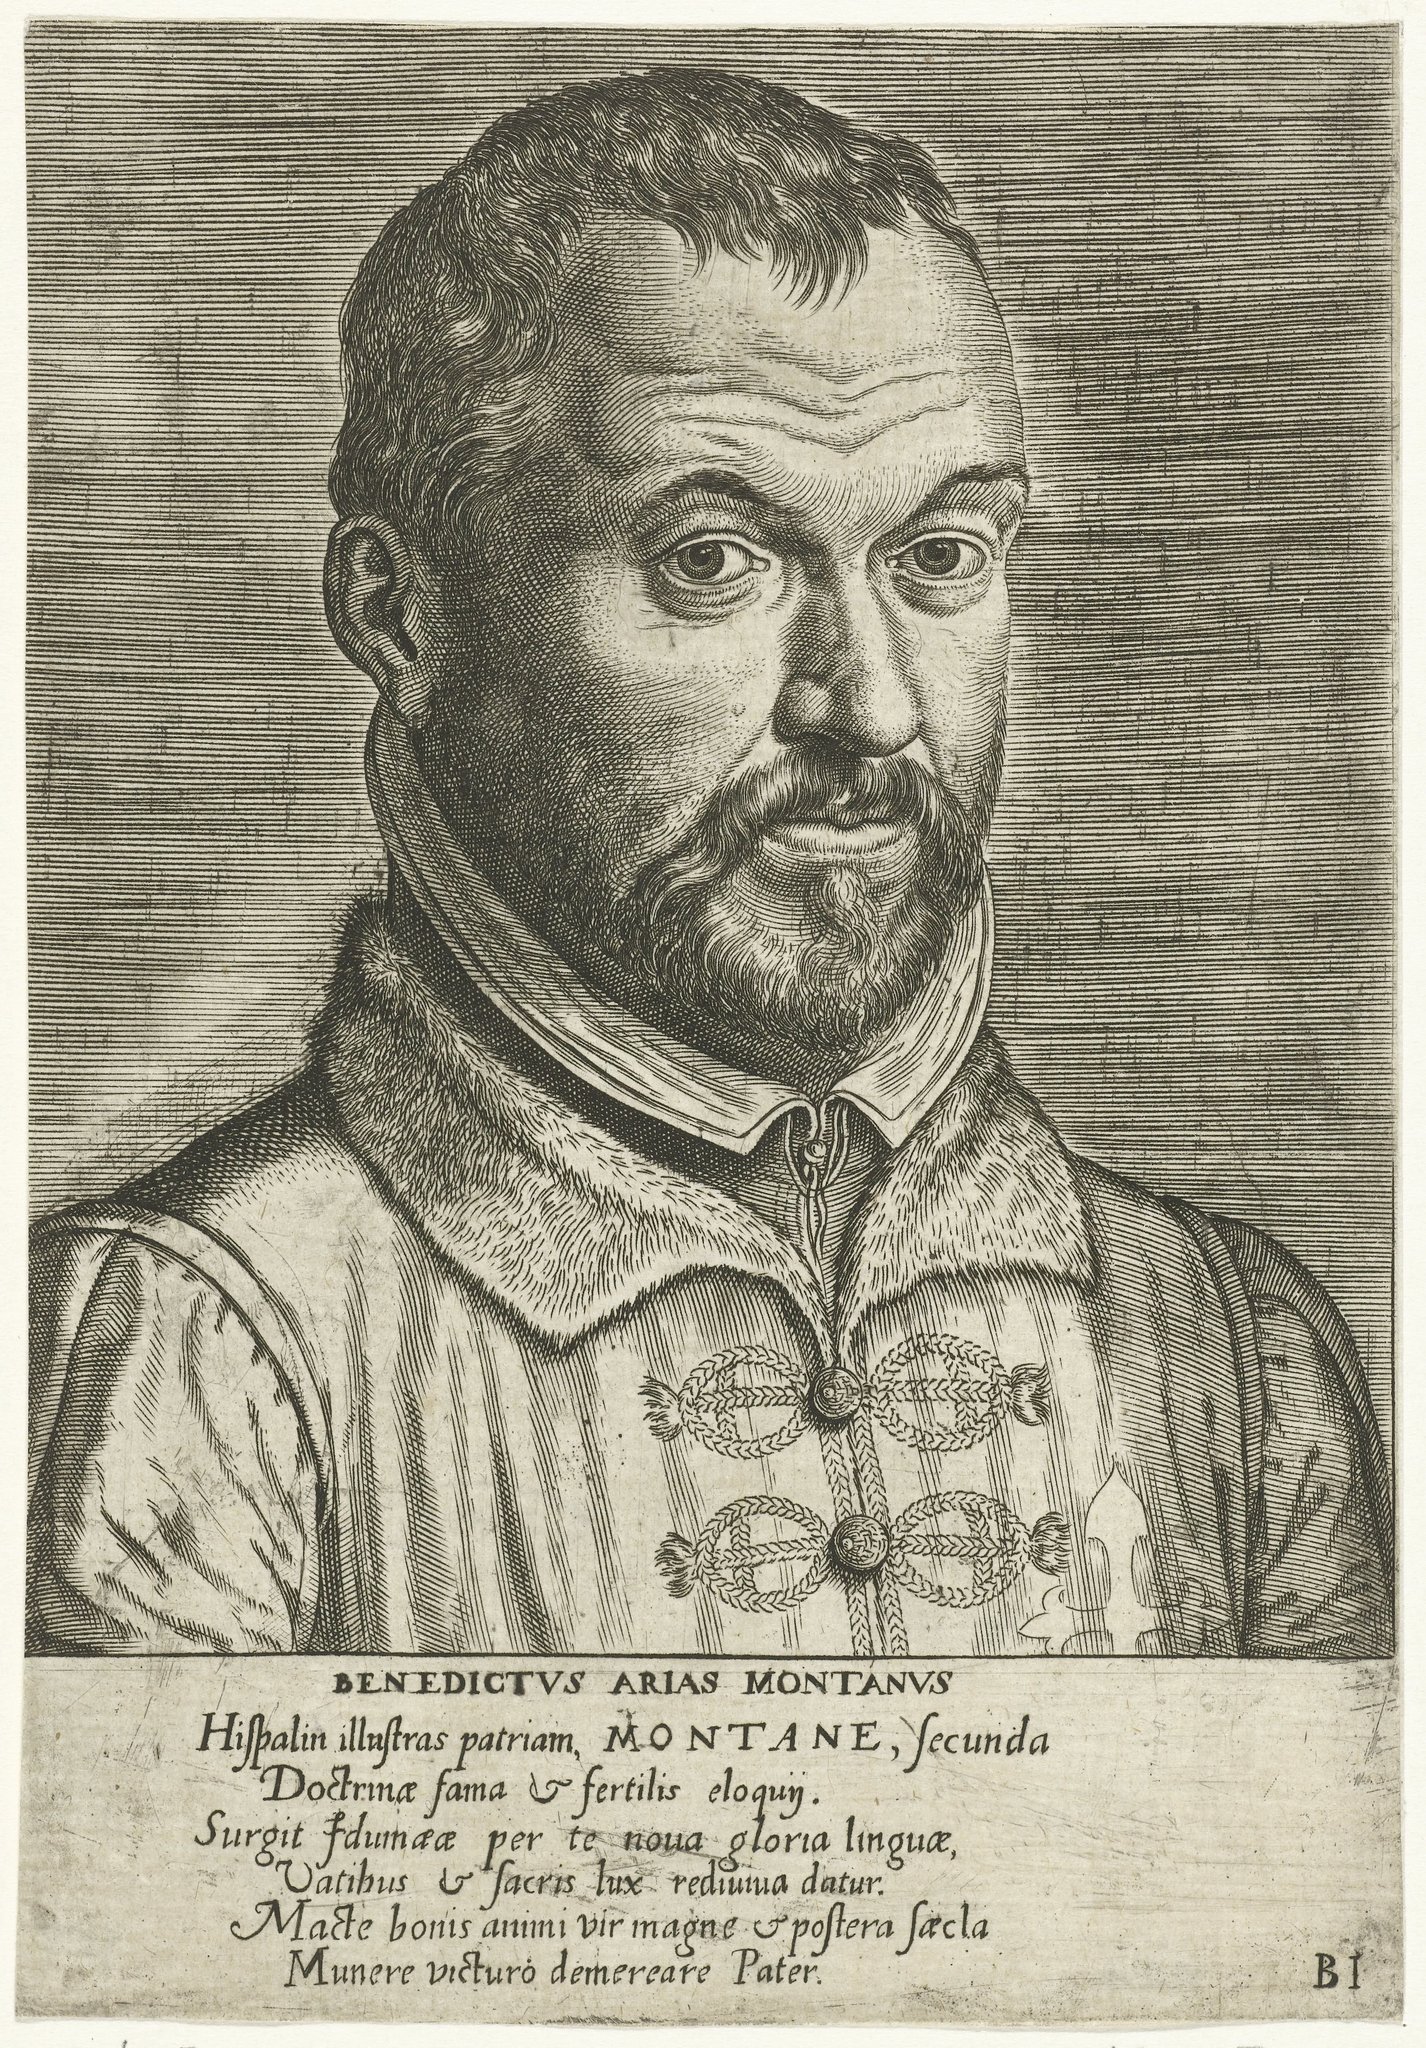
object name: print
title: Portretten van beroemde Europese geleerden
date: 1572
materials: paper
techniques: engraving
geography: antwerp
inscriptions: collector's mark: Lugt 2228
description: Portret van Benito Arias Montano, een Spaanse schrijver en theoloog. Buste naar rechts. Genummerd B1. De prent heeft een Latijns onderschrift en maakt deel uit van een serie van beroemde Europese geleerden.